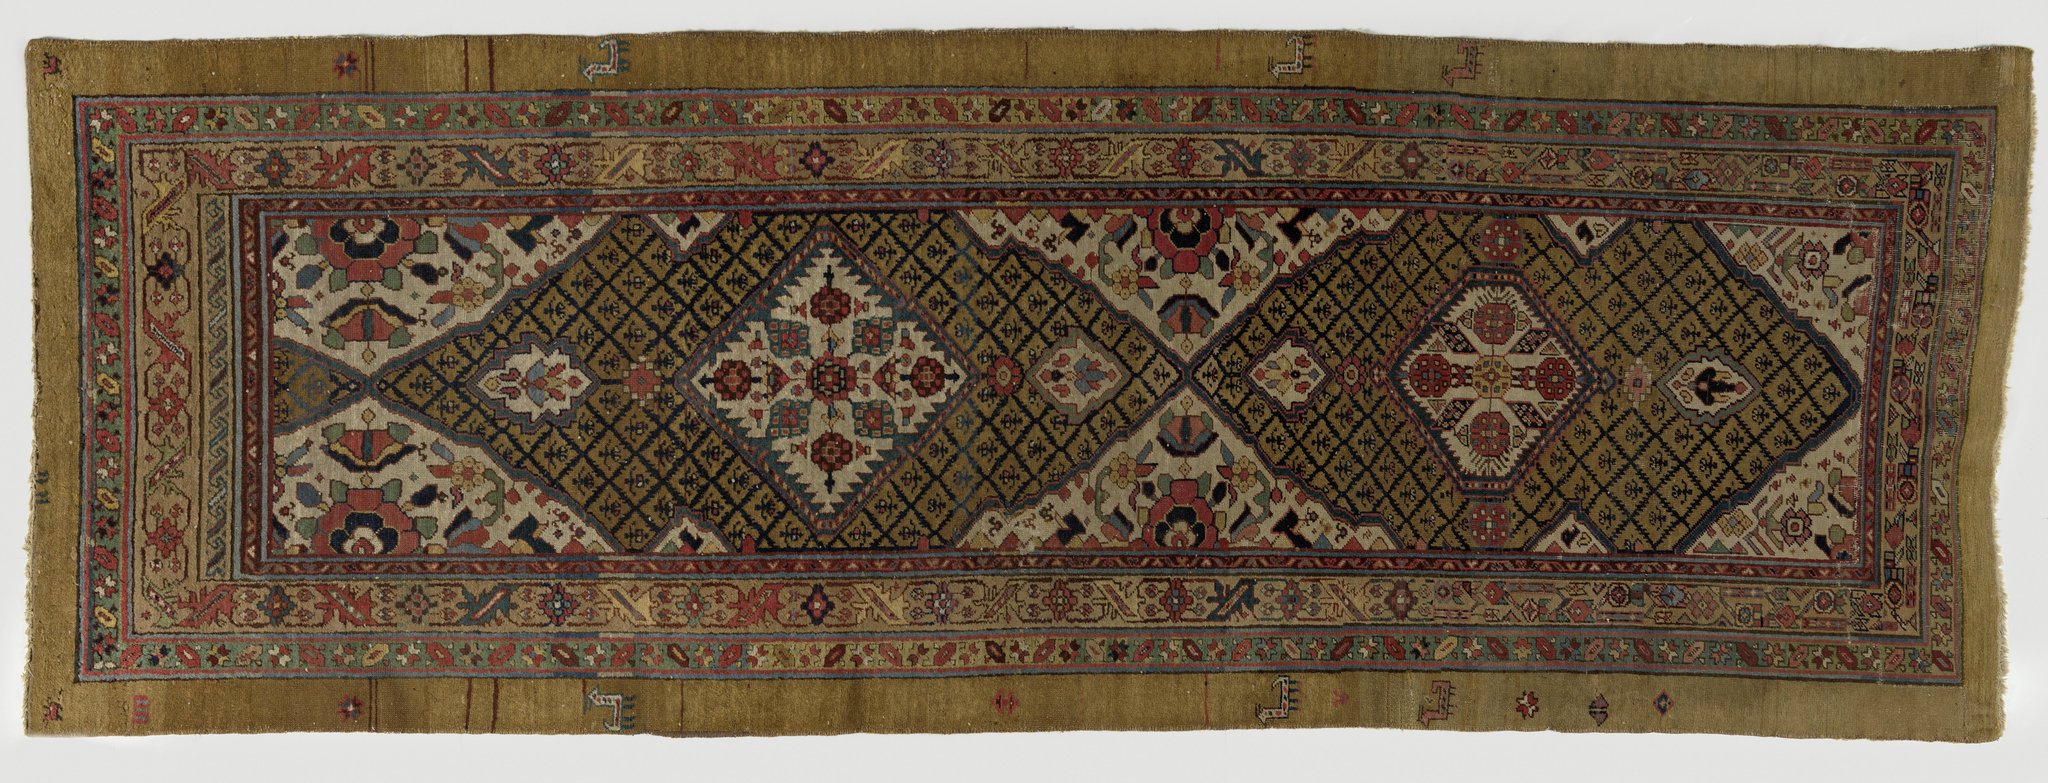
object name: oriental rug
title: Oosters tapijt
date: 1850-1900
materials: wool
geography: hamadan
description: Oosters medaillion- of rasterkleed van geknoopte wol, loperformaat. Op het middenveld staan twee langgerekte medaillons en hieromheen vier randen.